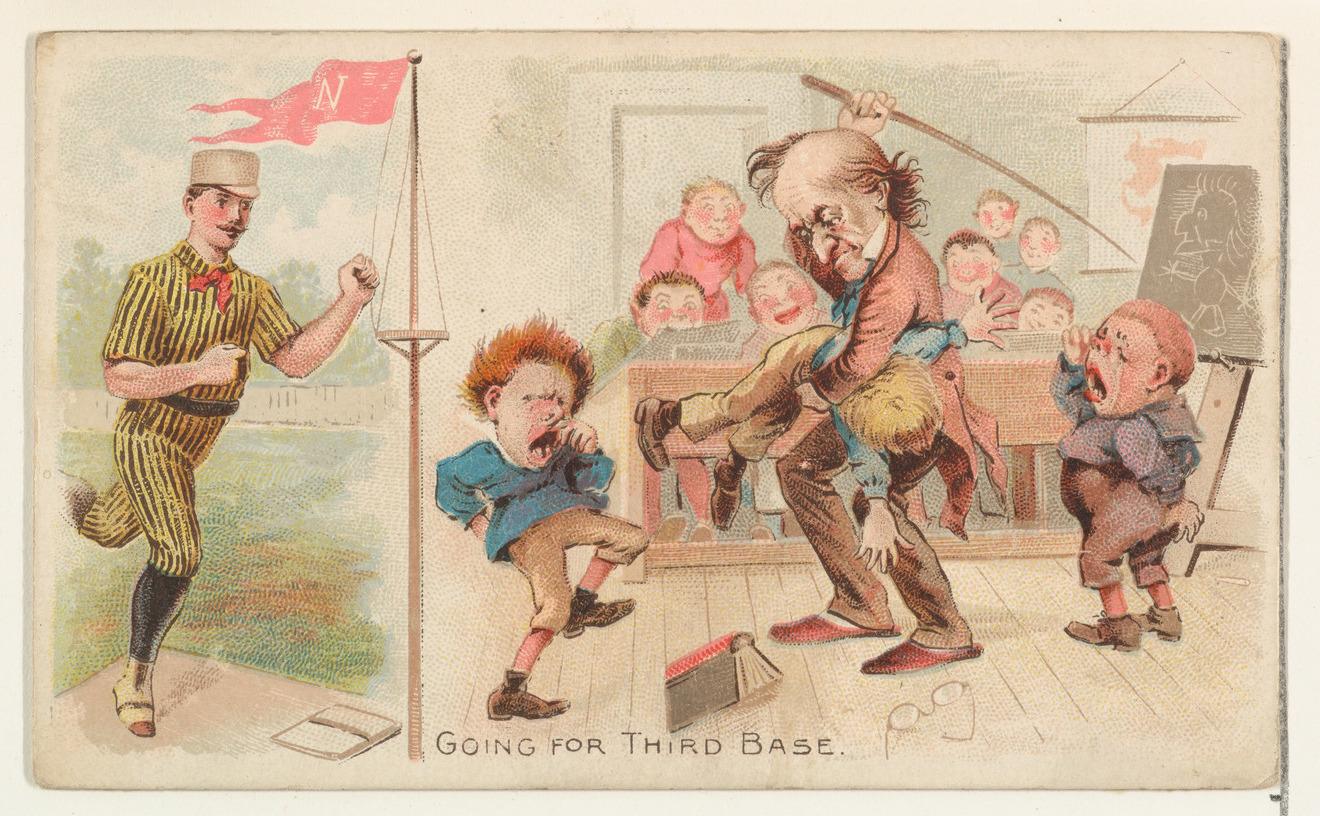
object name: print, baseball card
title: Going For Third Base, from the Talk of the Diamond set (N135) issued by Duke Sons & Co., a branch of the American Tobacco Company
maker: w. duke, sons & co.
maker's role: publisher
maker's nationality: american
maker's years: 1870-1920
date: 1888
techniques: color lithograph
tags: boys,men